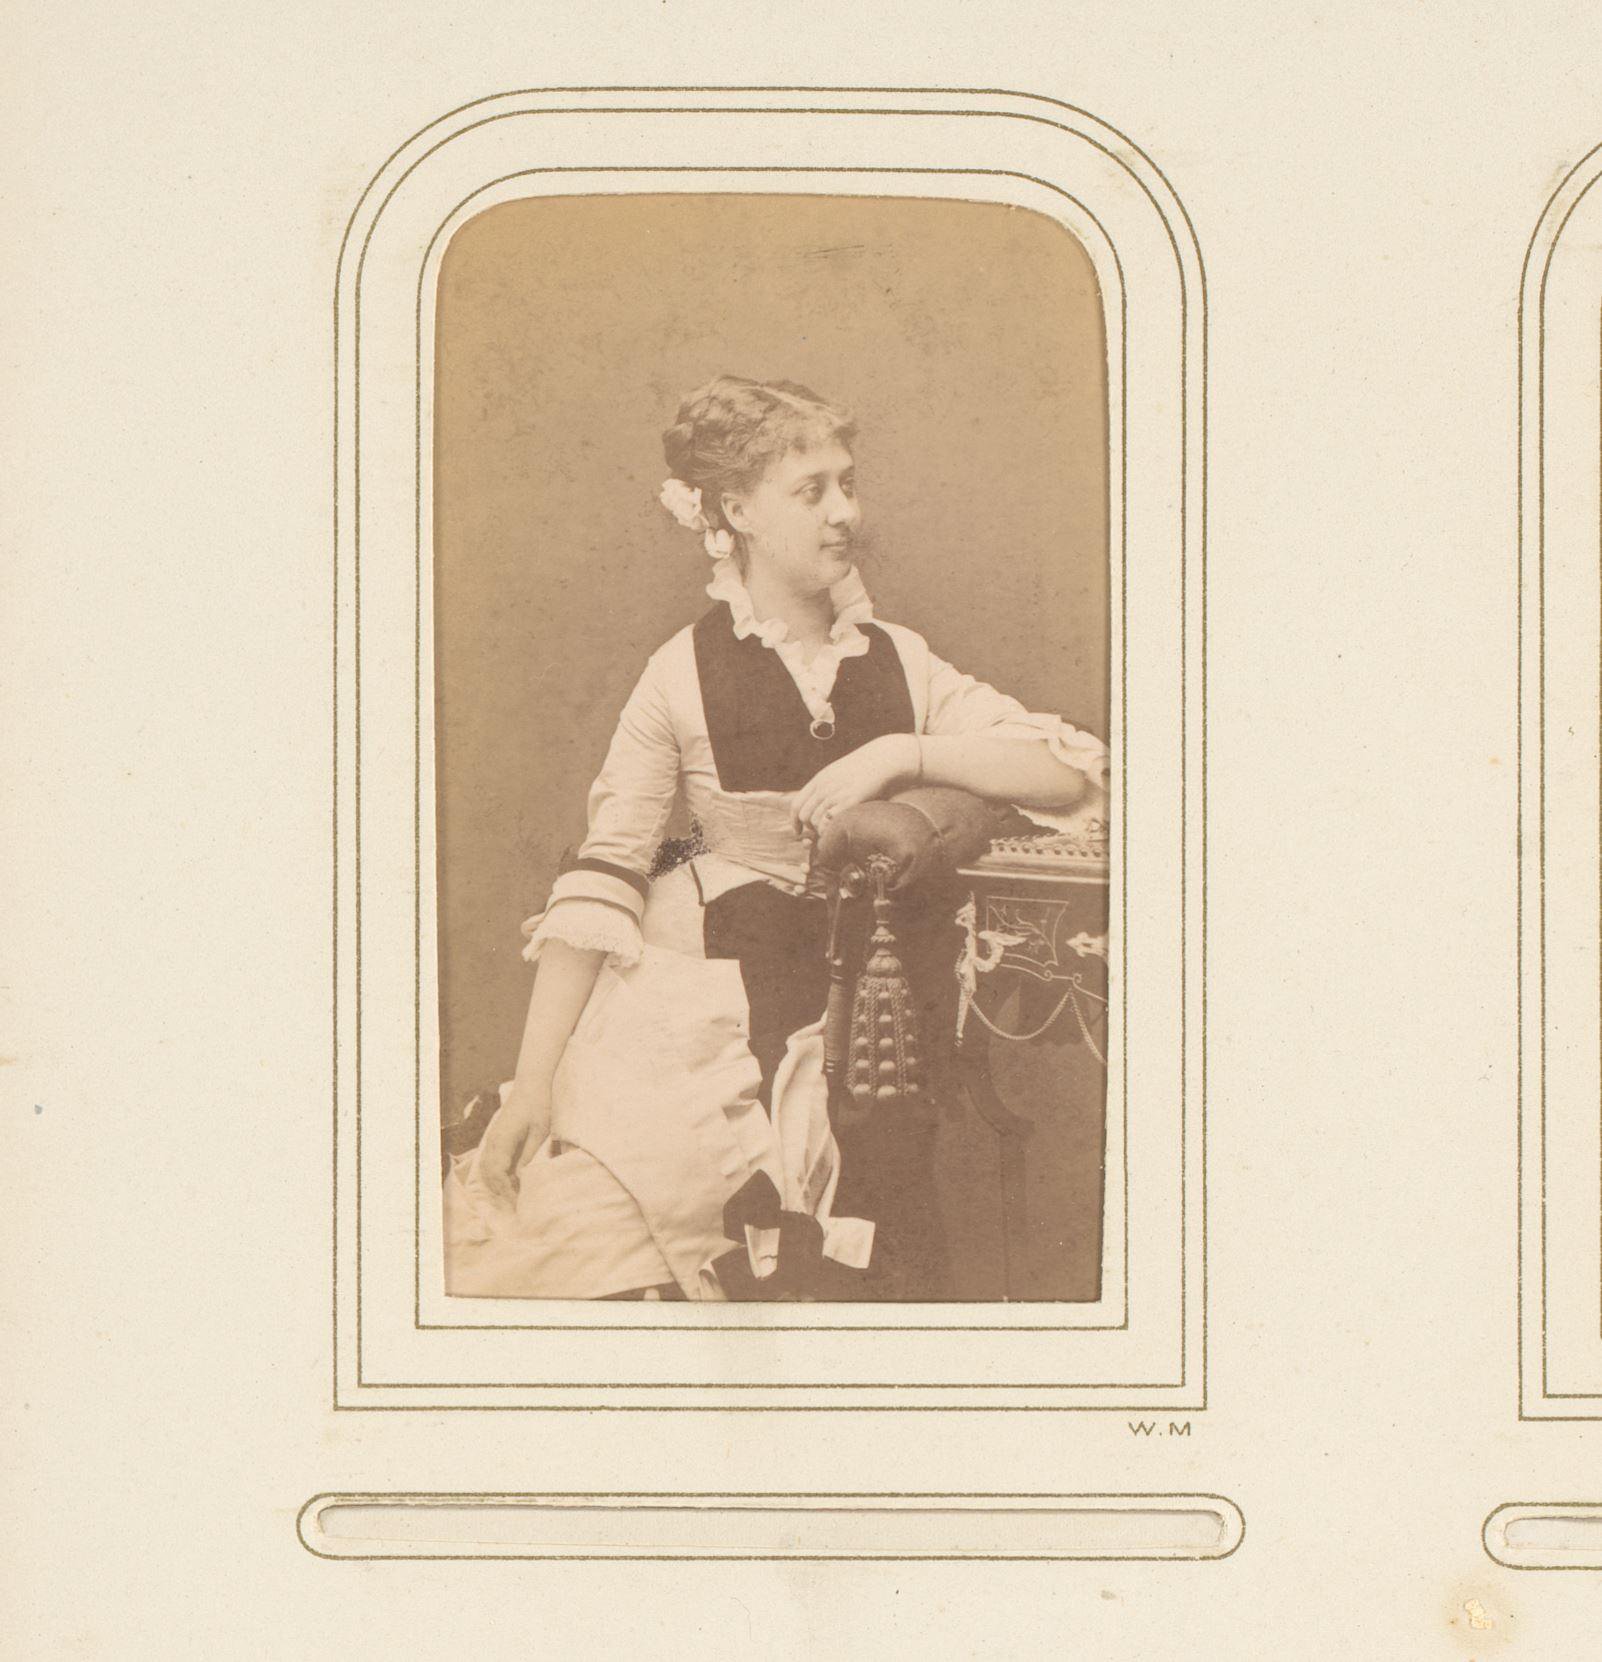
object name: album leaf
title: Portret van Anna Byström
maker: gösta florman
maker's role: fotograaf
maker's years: 1831-1900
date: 1874-1890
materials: cardboard, photographic support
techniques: albumen print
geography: stockholm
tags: historical persons - bb - woman, portrait of actor, actress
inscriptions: annotation: ‘Anna Sternvall/ b. Byström/ 1854 -’, inscription: ‘Gösta Florman/ STOCKHOLM/ 28A Regeringsgatan 28 A.’